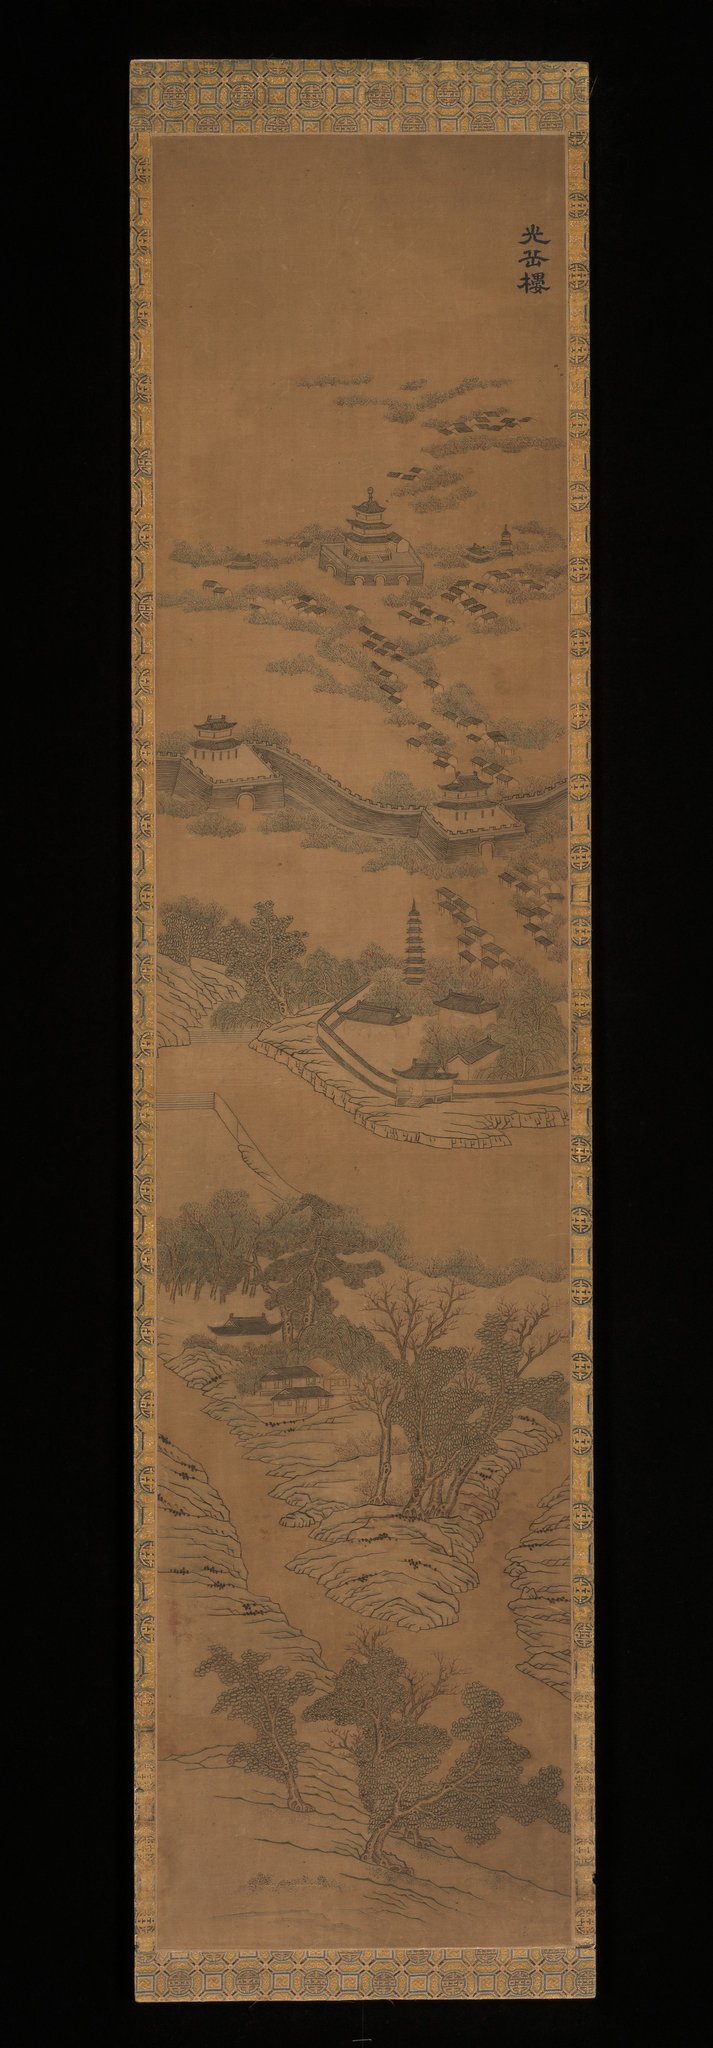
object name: kesi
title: Scenic Sites in the Qianlong Emperor’s Southern Inspection Tour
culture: chinese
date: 1801-1900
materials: ink, silk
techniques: tapestry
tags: landscapes